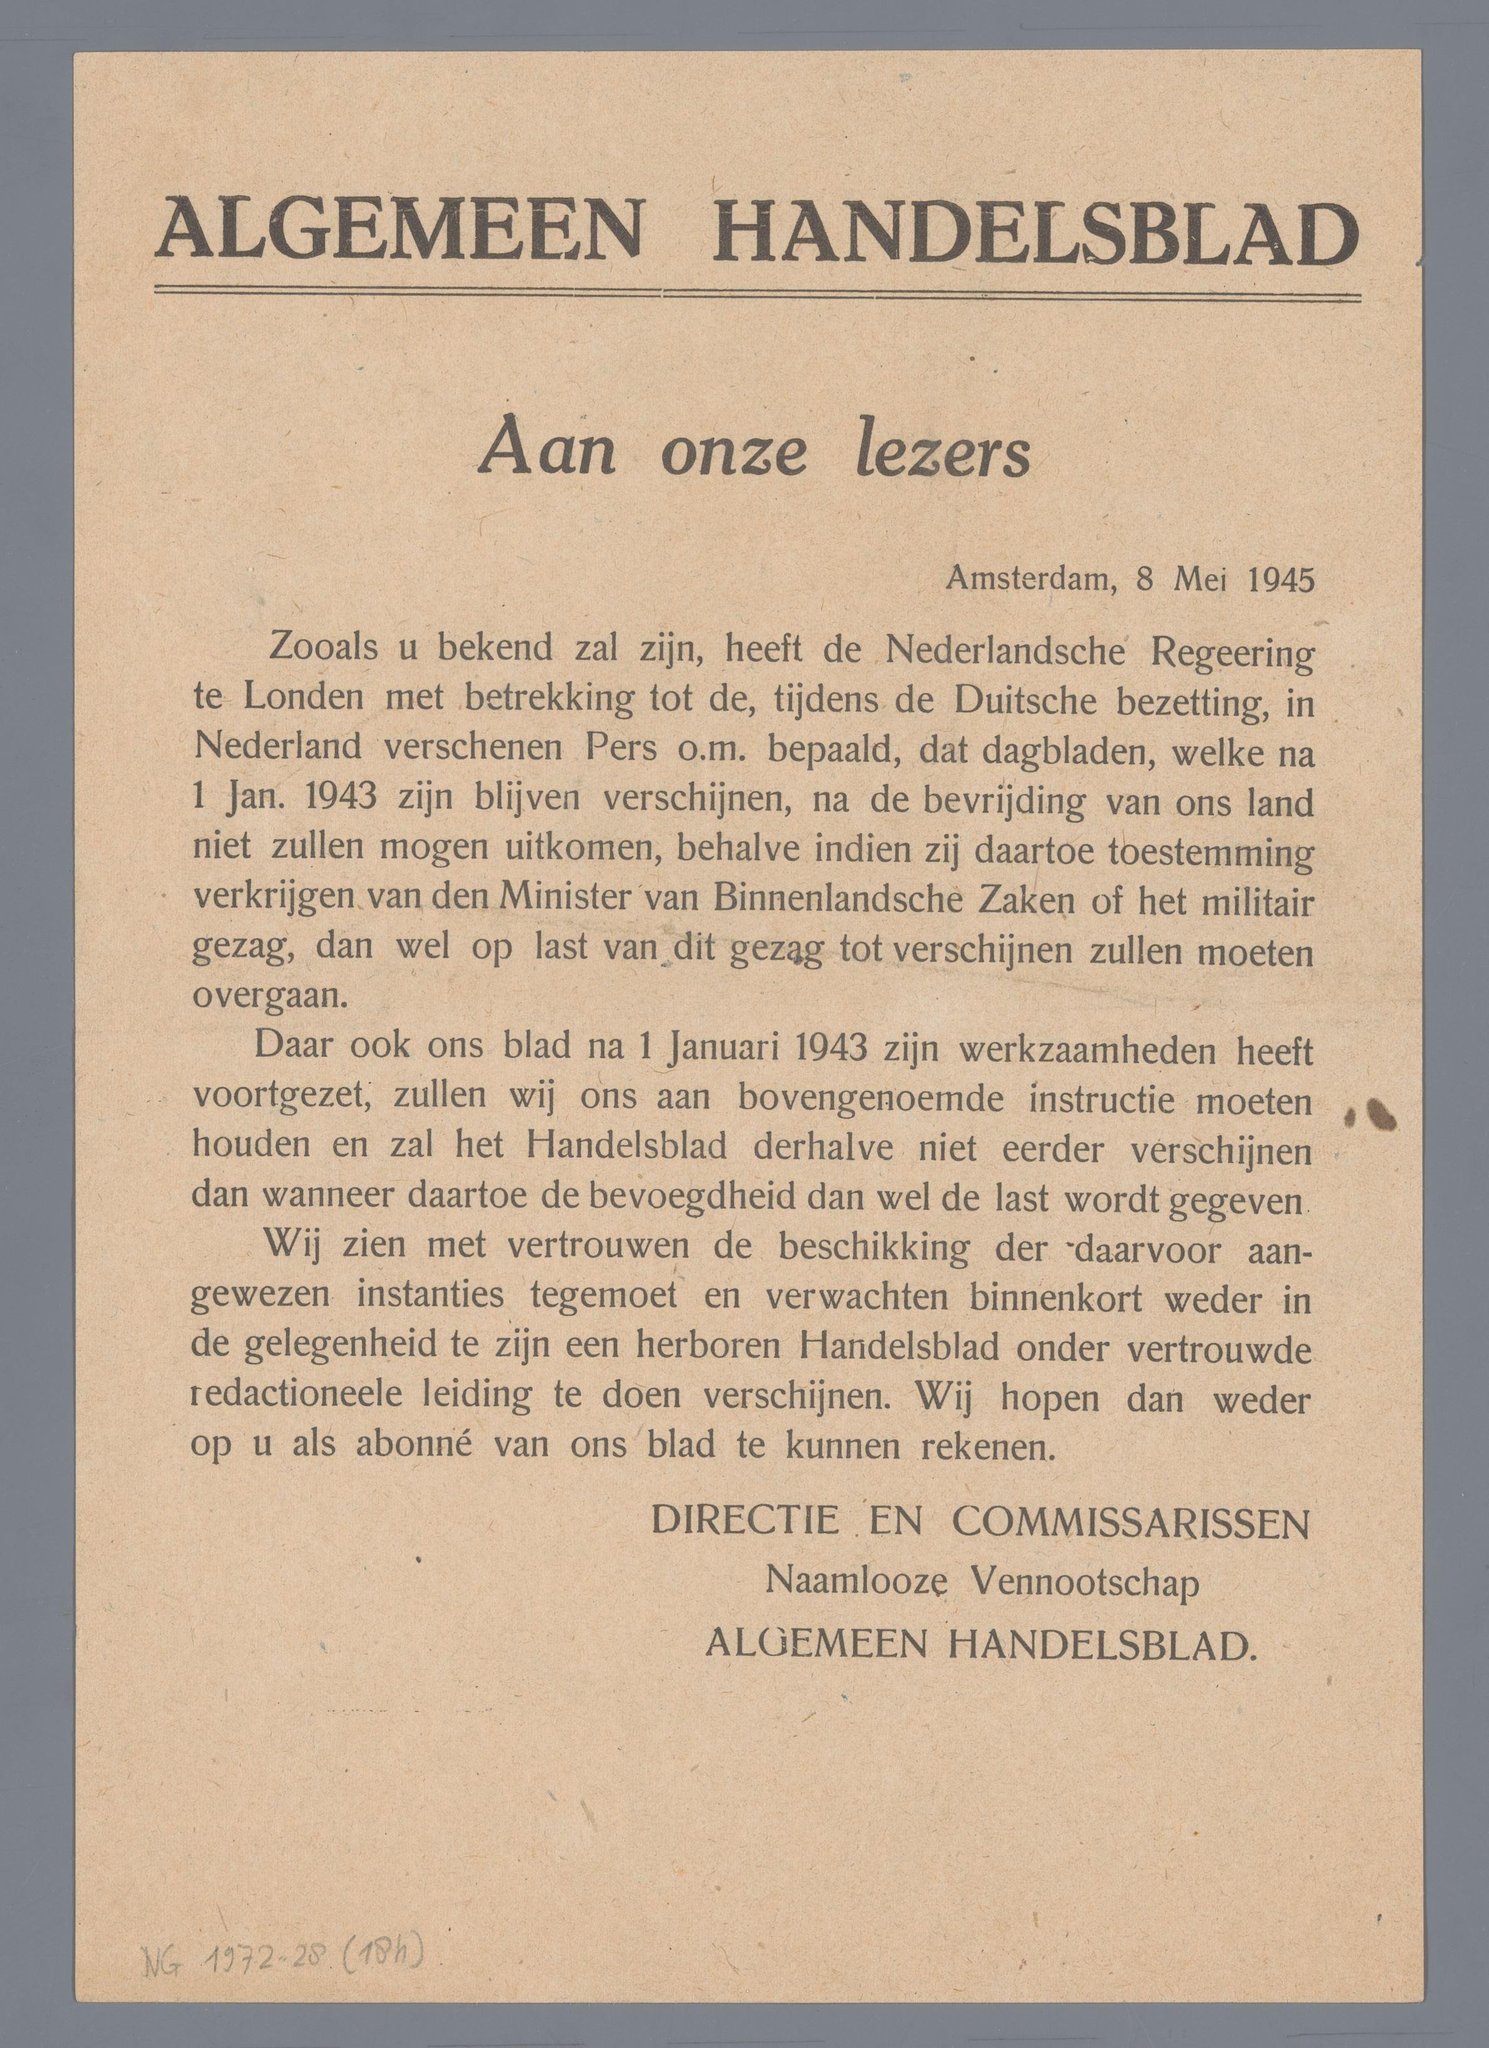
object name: newspaper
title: Algemeen Handelsblad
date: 1945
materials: paper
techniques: printing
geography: amsterdam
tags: netherlands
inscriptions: date